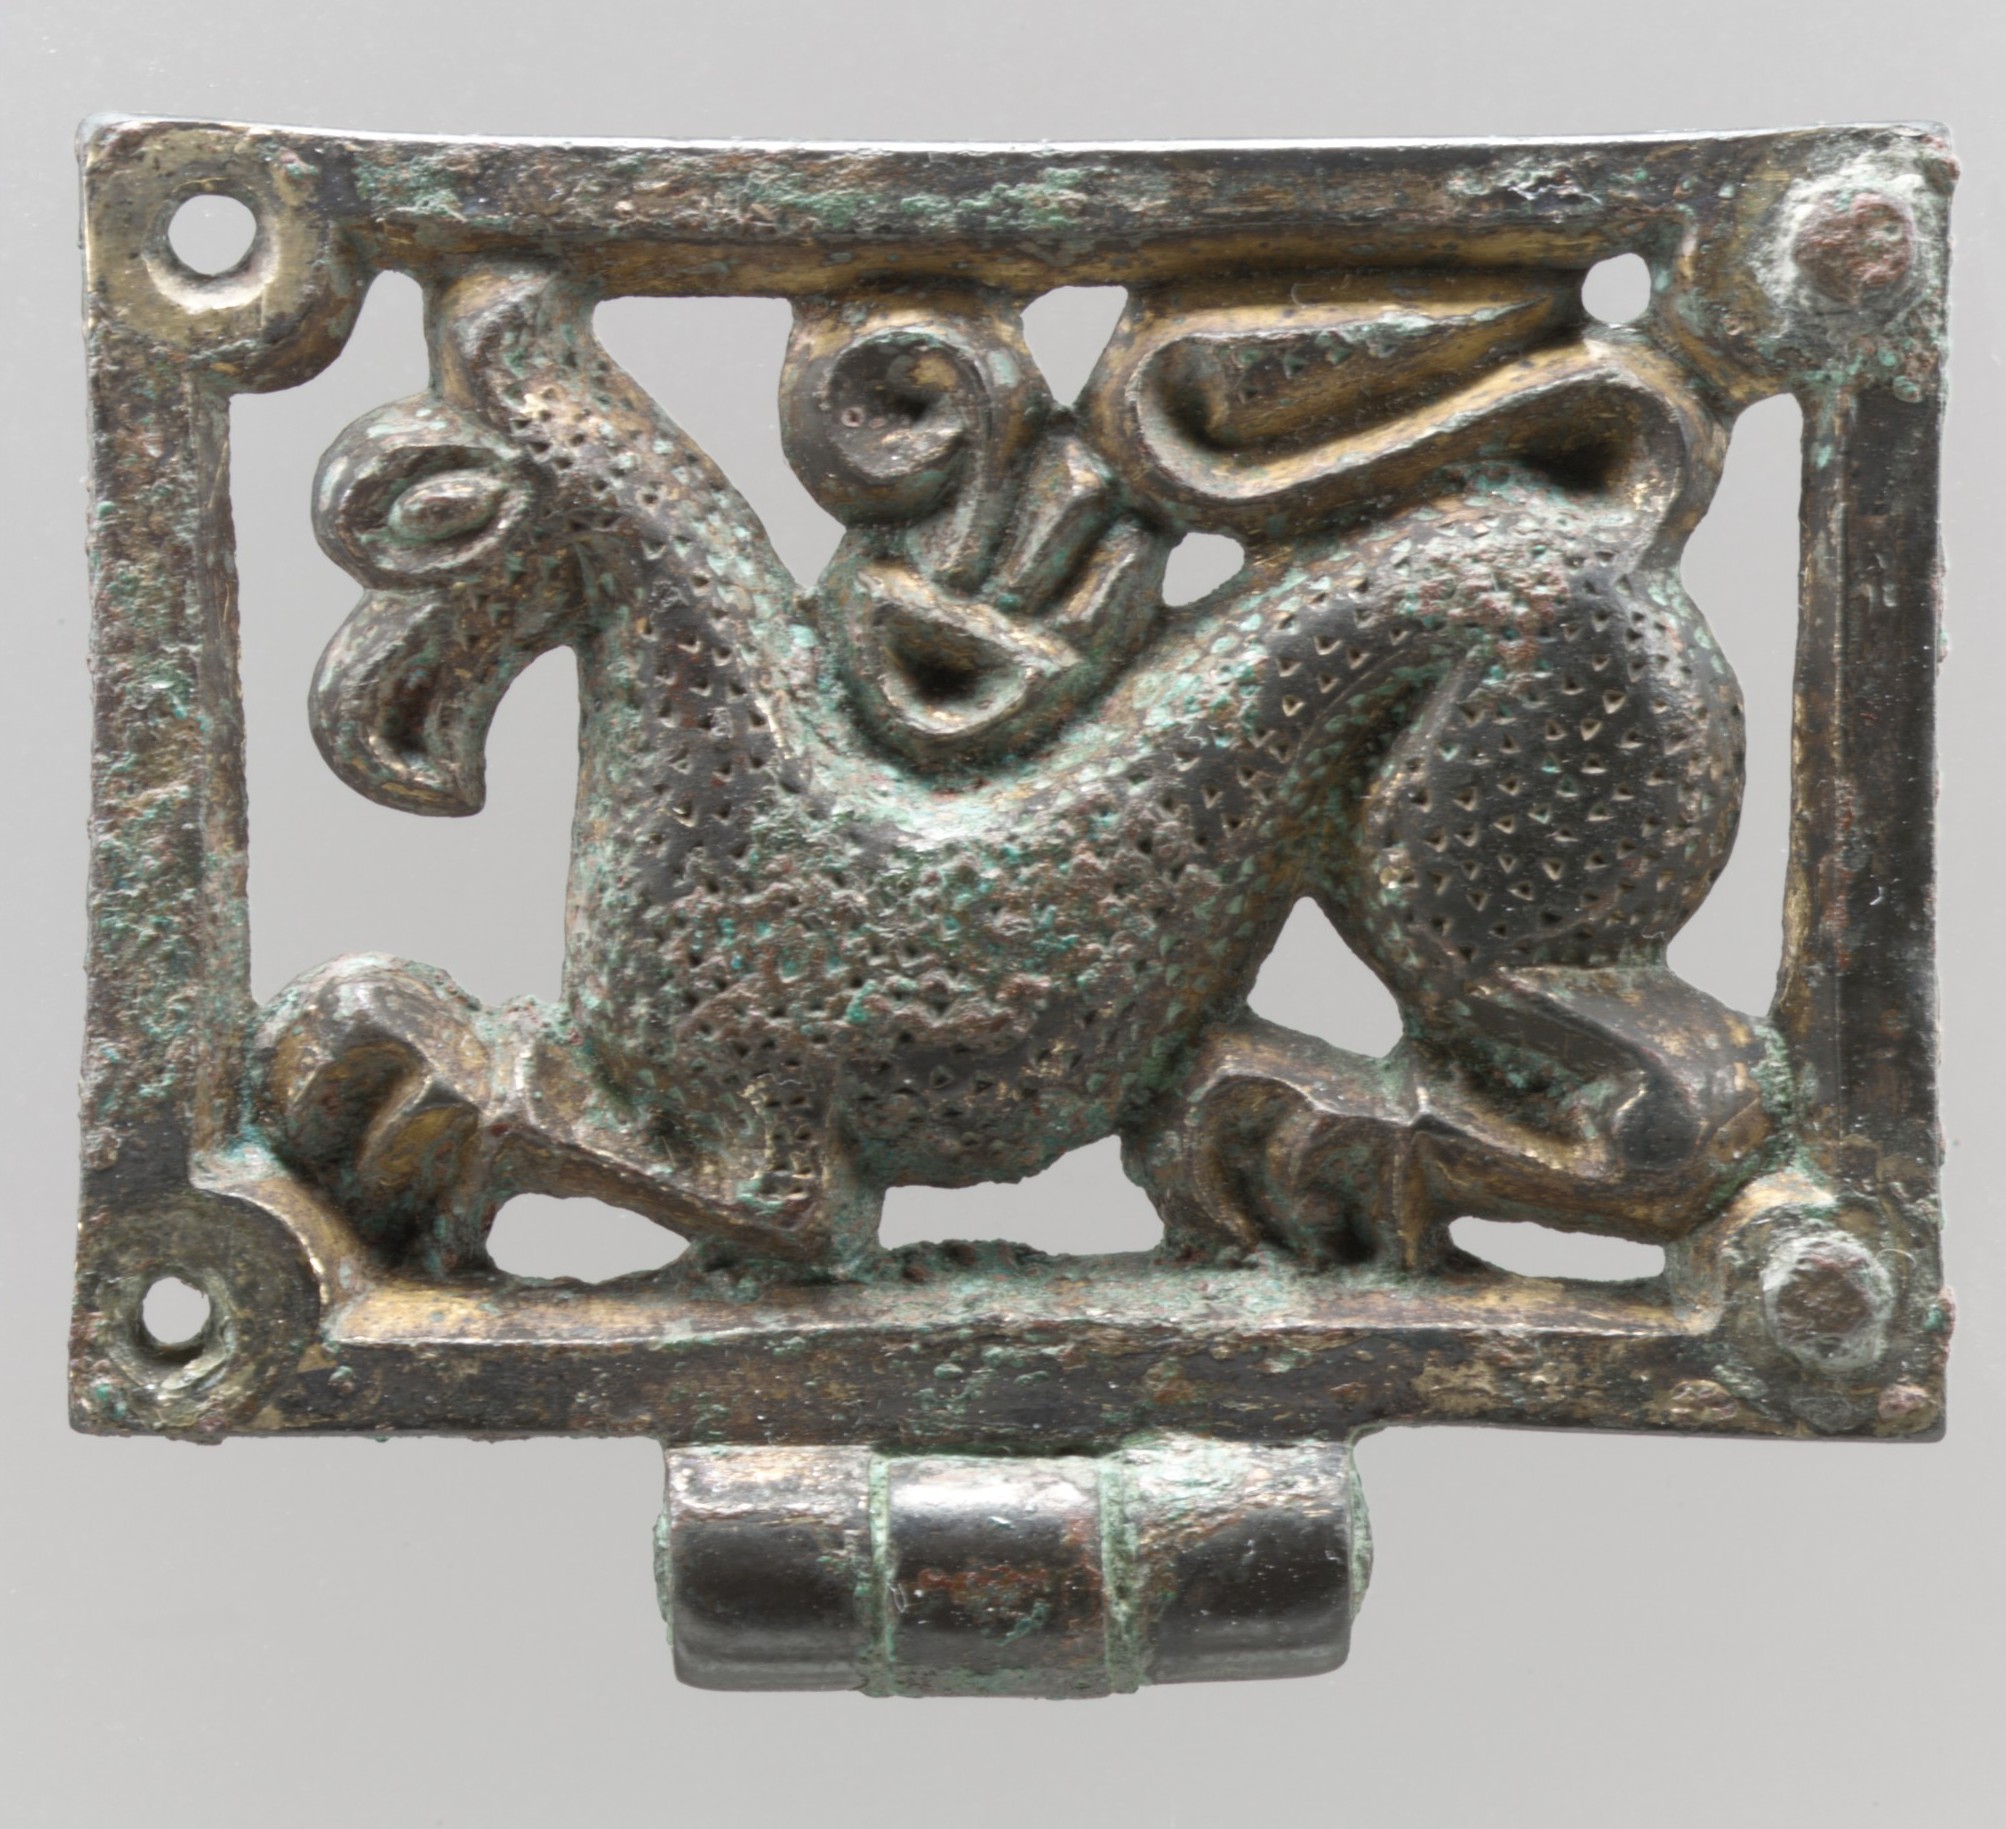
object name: belt fitting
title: Belt Mount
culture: avar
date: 701-800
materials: copper alloy, gilt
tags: griffins